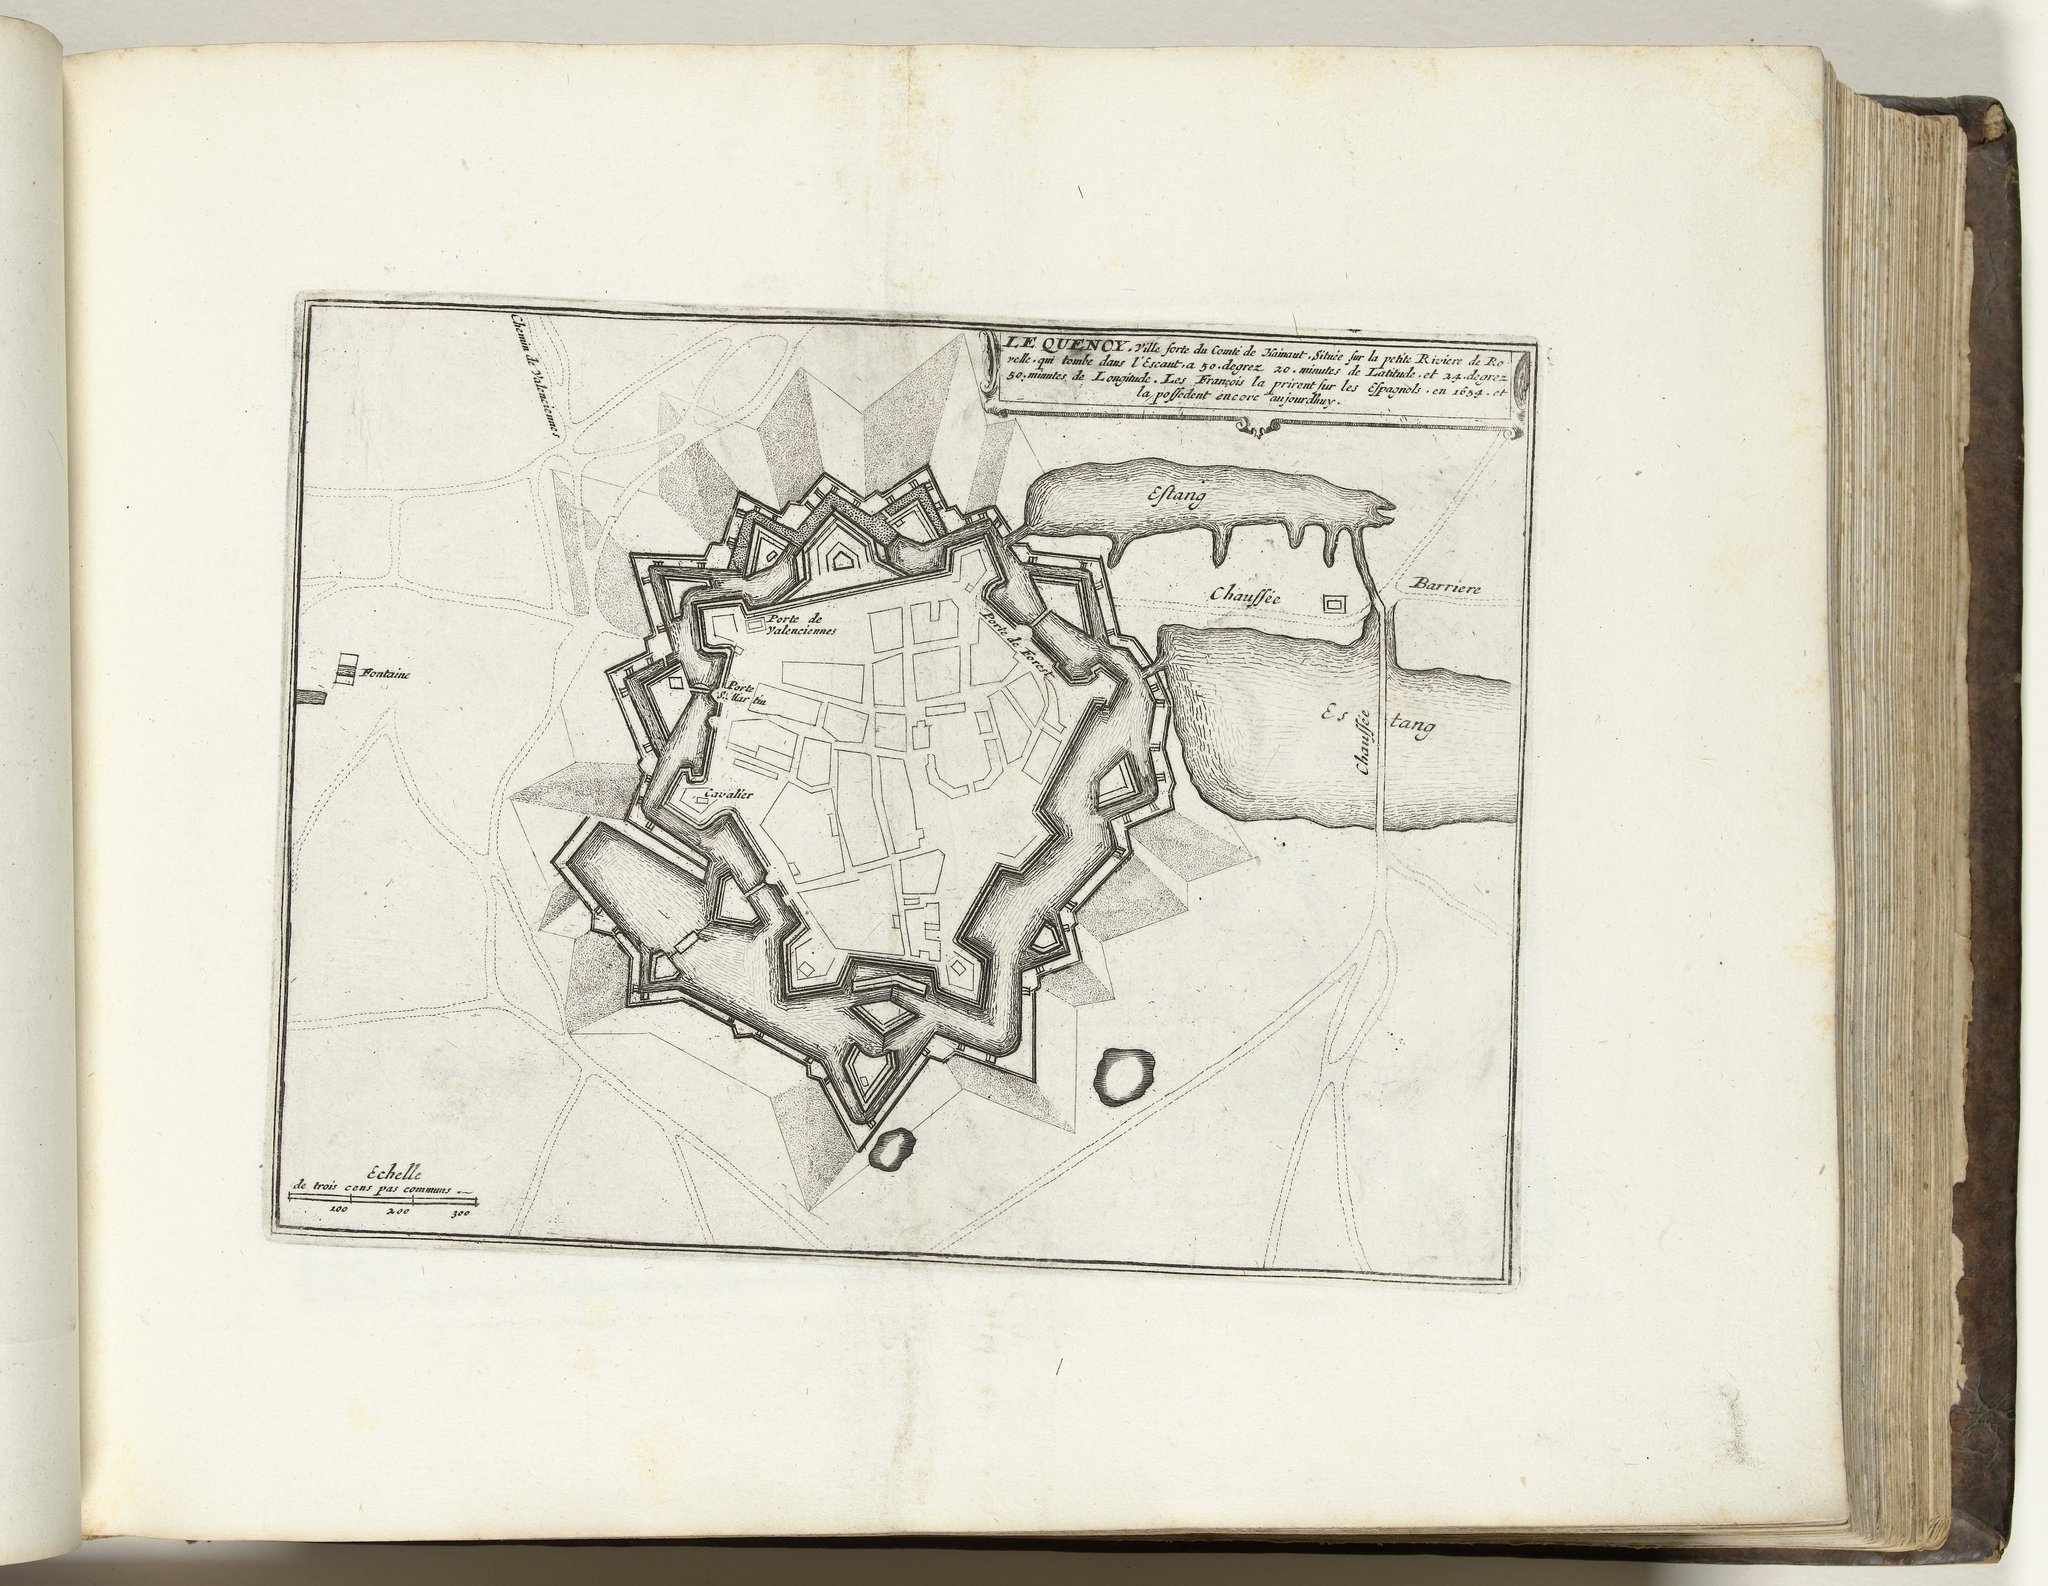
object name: map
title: Le Quenoy, Ville forte du Comté de Hainaut (...)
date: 1693-1695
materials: paper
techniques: etching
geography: france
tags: fortress, maps of cities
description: Plattegrond van de versterkingen om de stad le Quesnoy. Onderdeel van het derde deel (1695) van het prentwerk waarin gebundeld zijn de acht delen van Les forces de l'Europe uitgegeven tussen 1693-1697. Het prentwerk bestaat uit 175 platen met plannen (afkomstig van Sébastien Le Prestre, Seigneur de Vauban) van vermaarde sterke steden en vestingen in de Negenjarige Oorlog. Titel en opschriften in het Frans.